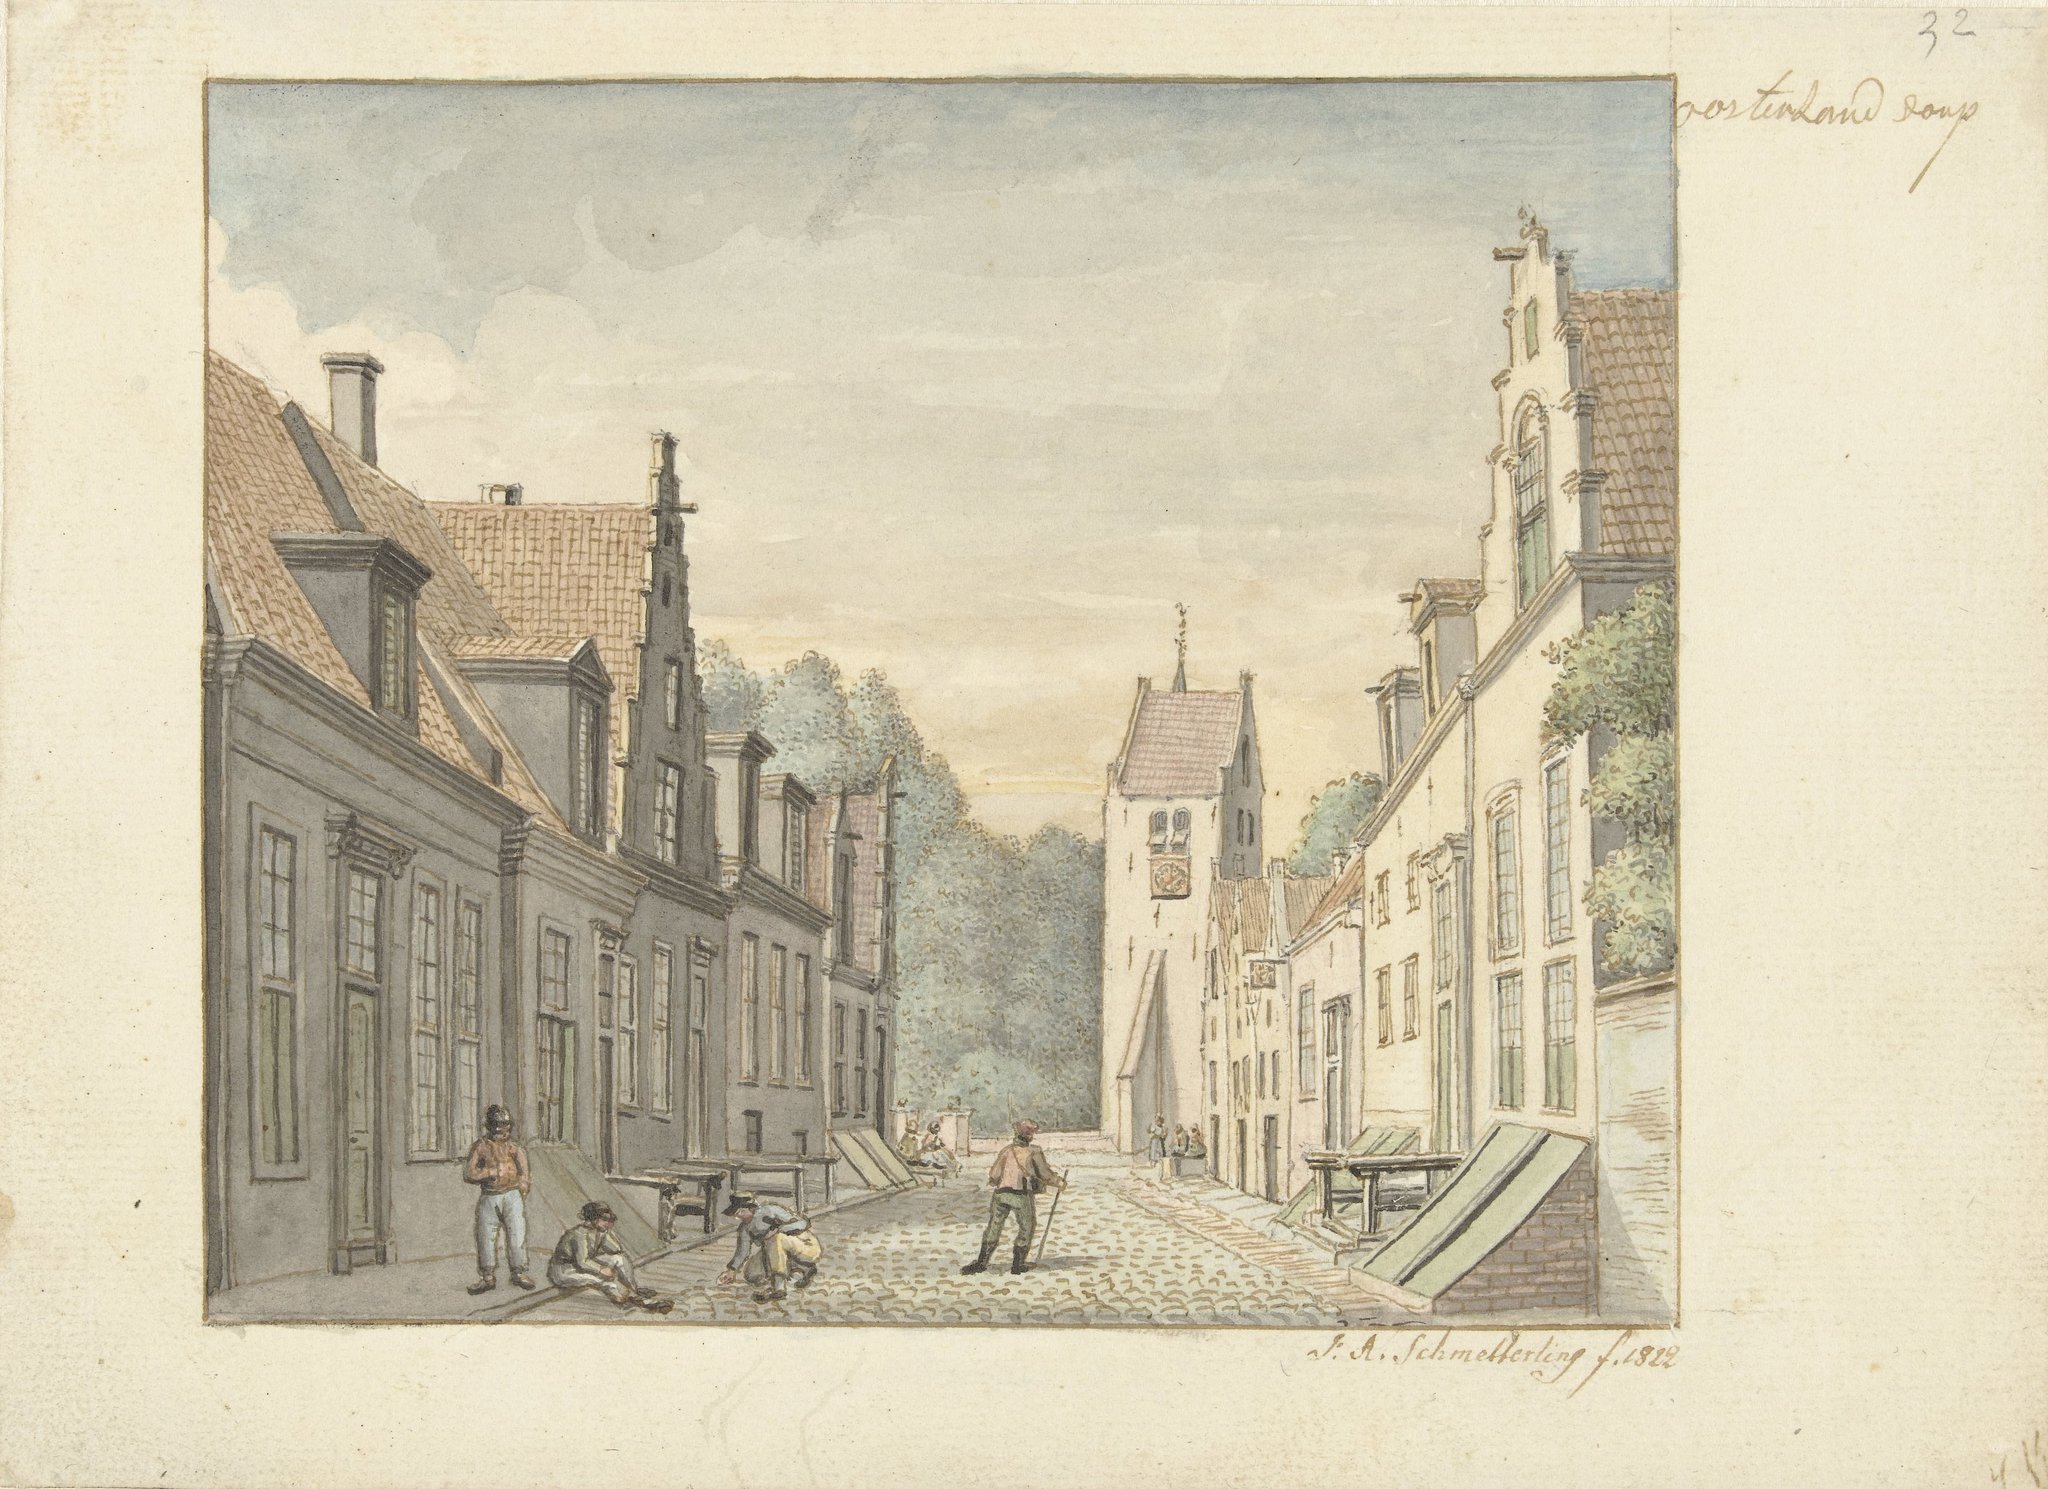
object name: drawing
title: Straat in het dorp Oosterland op Duiveland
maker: joseph adolf schmetterling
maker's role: draughtsman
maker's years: 1751-1828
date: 1822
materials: ink, paper, watercolor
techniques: brush, pen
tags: village street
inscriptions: date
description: Straat in het dorp Oosterland op Duiveland; op de achtergrond de kerktoren.